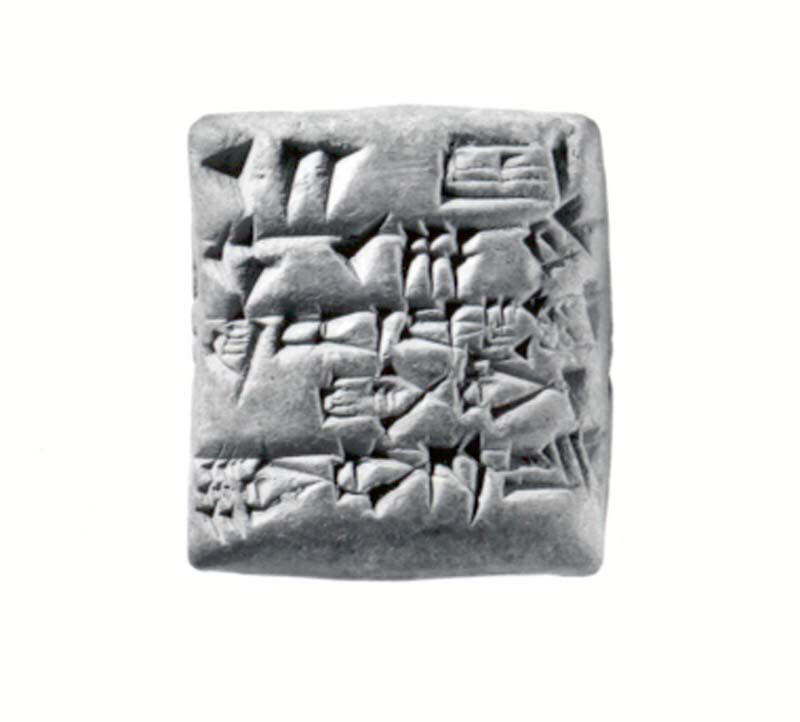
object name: cuneiform tablet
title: Cuneiform tablet: receipt of lambs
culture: neo-sumerian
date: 2041 BCE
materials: clay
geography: mesopotamia